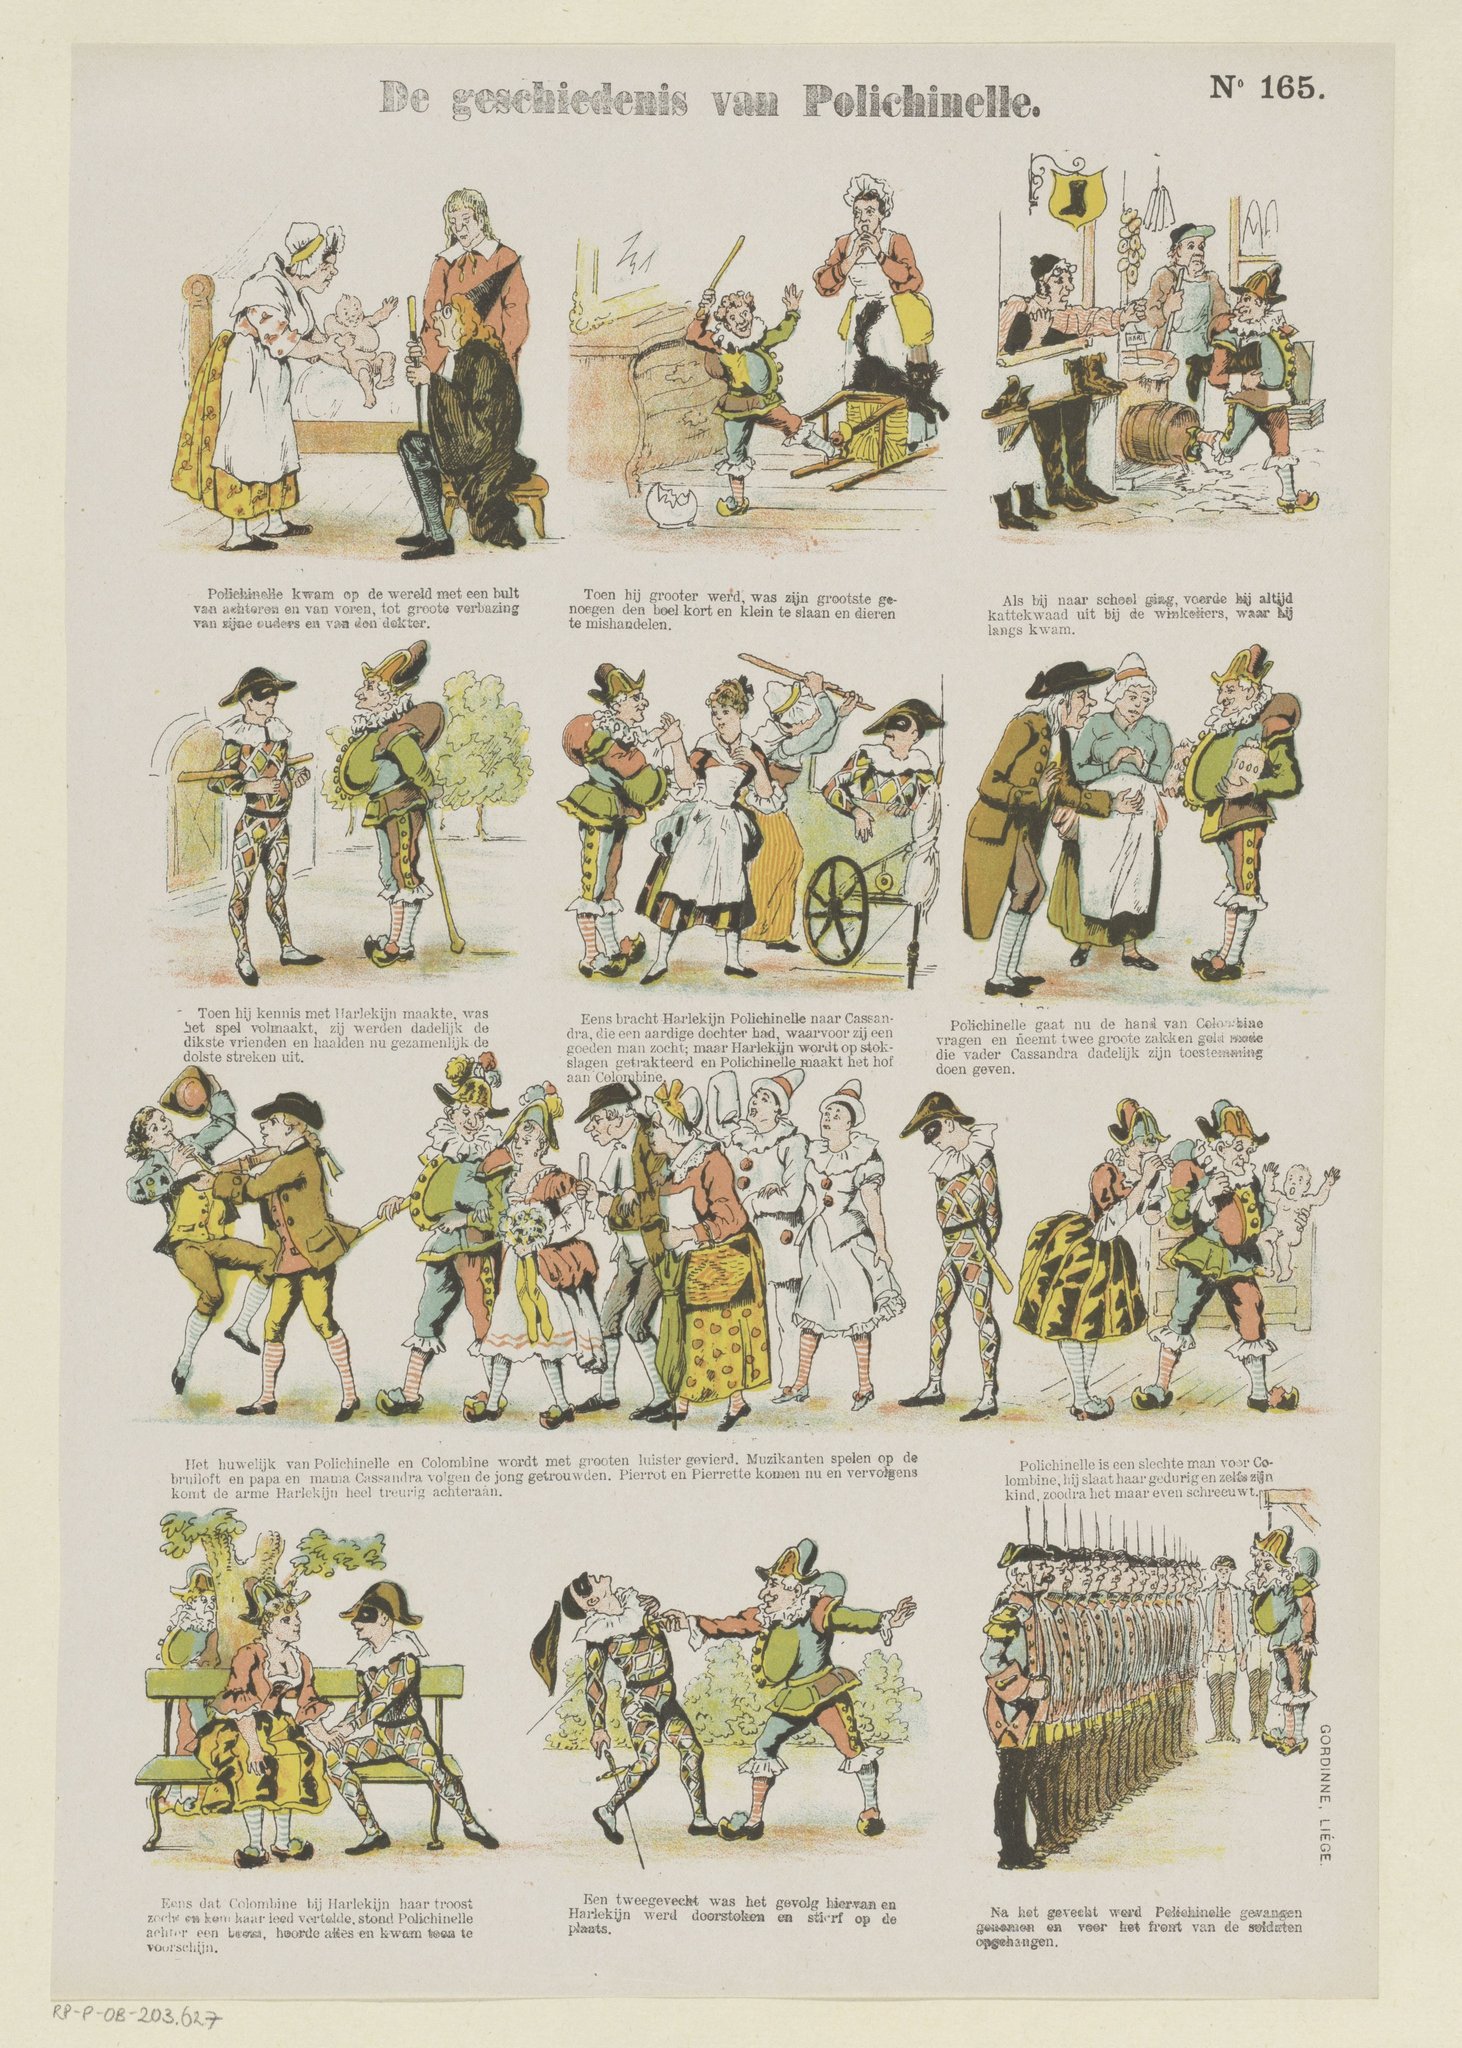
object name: popular print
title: De geschiedenis van Polichinelle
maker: Anonymous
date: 1894-1959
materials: paper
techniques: lithograph, letterpress printing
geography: liège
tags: types in 'commedia dell'arte': pulcinella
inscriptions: collector's mark: Lugt 2760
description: Blad met 11 voorstellingen over het leven van de gebochelde Polichinelle (Pulcinella). Onder elke afbeelding een onderschrift. Genummerd rechtsboven: No 165.